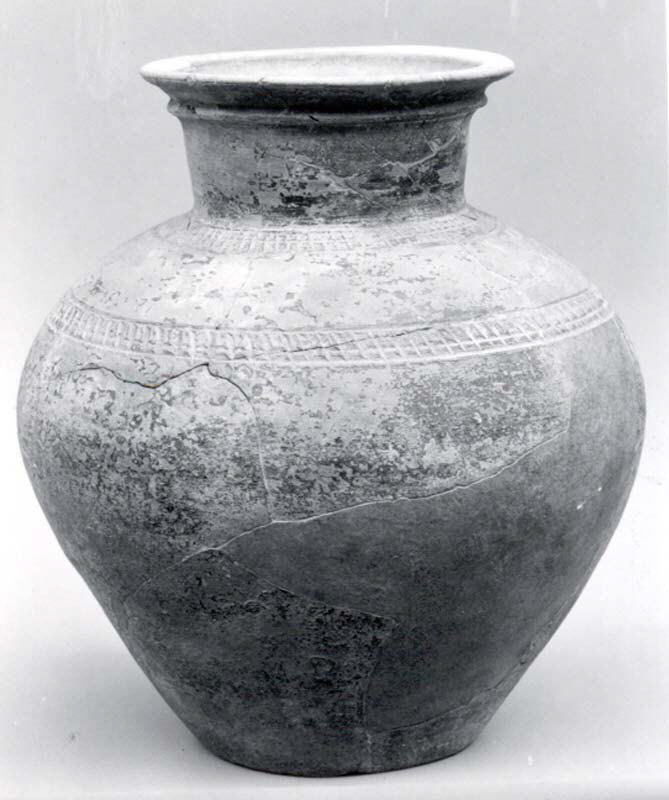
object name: jar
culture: sasanian or islamic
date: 501-800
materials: ceramic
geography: iran